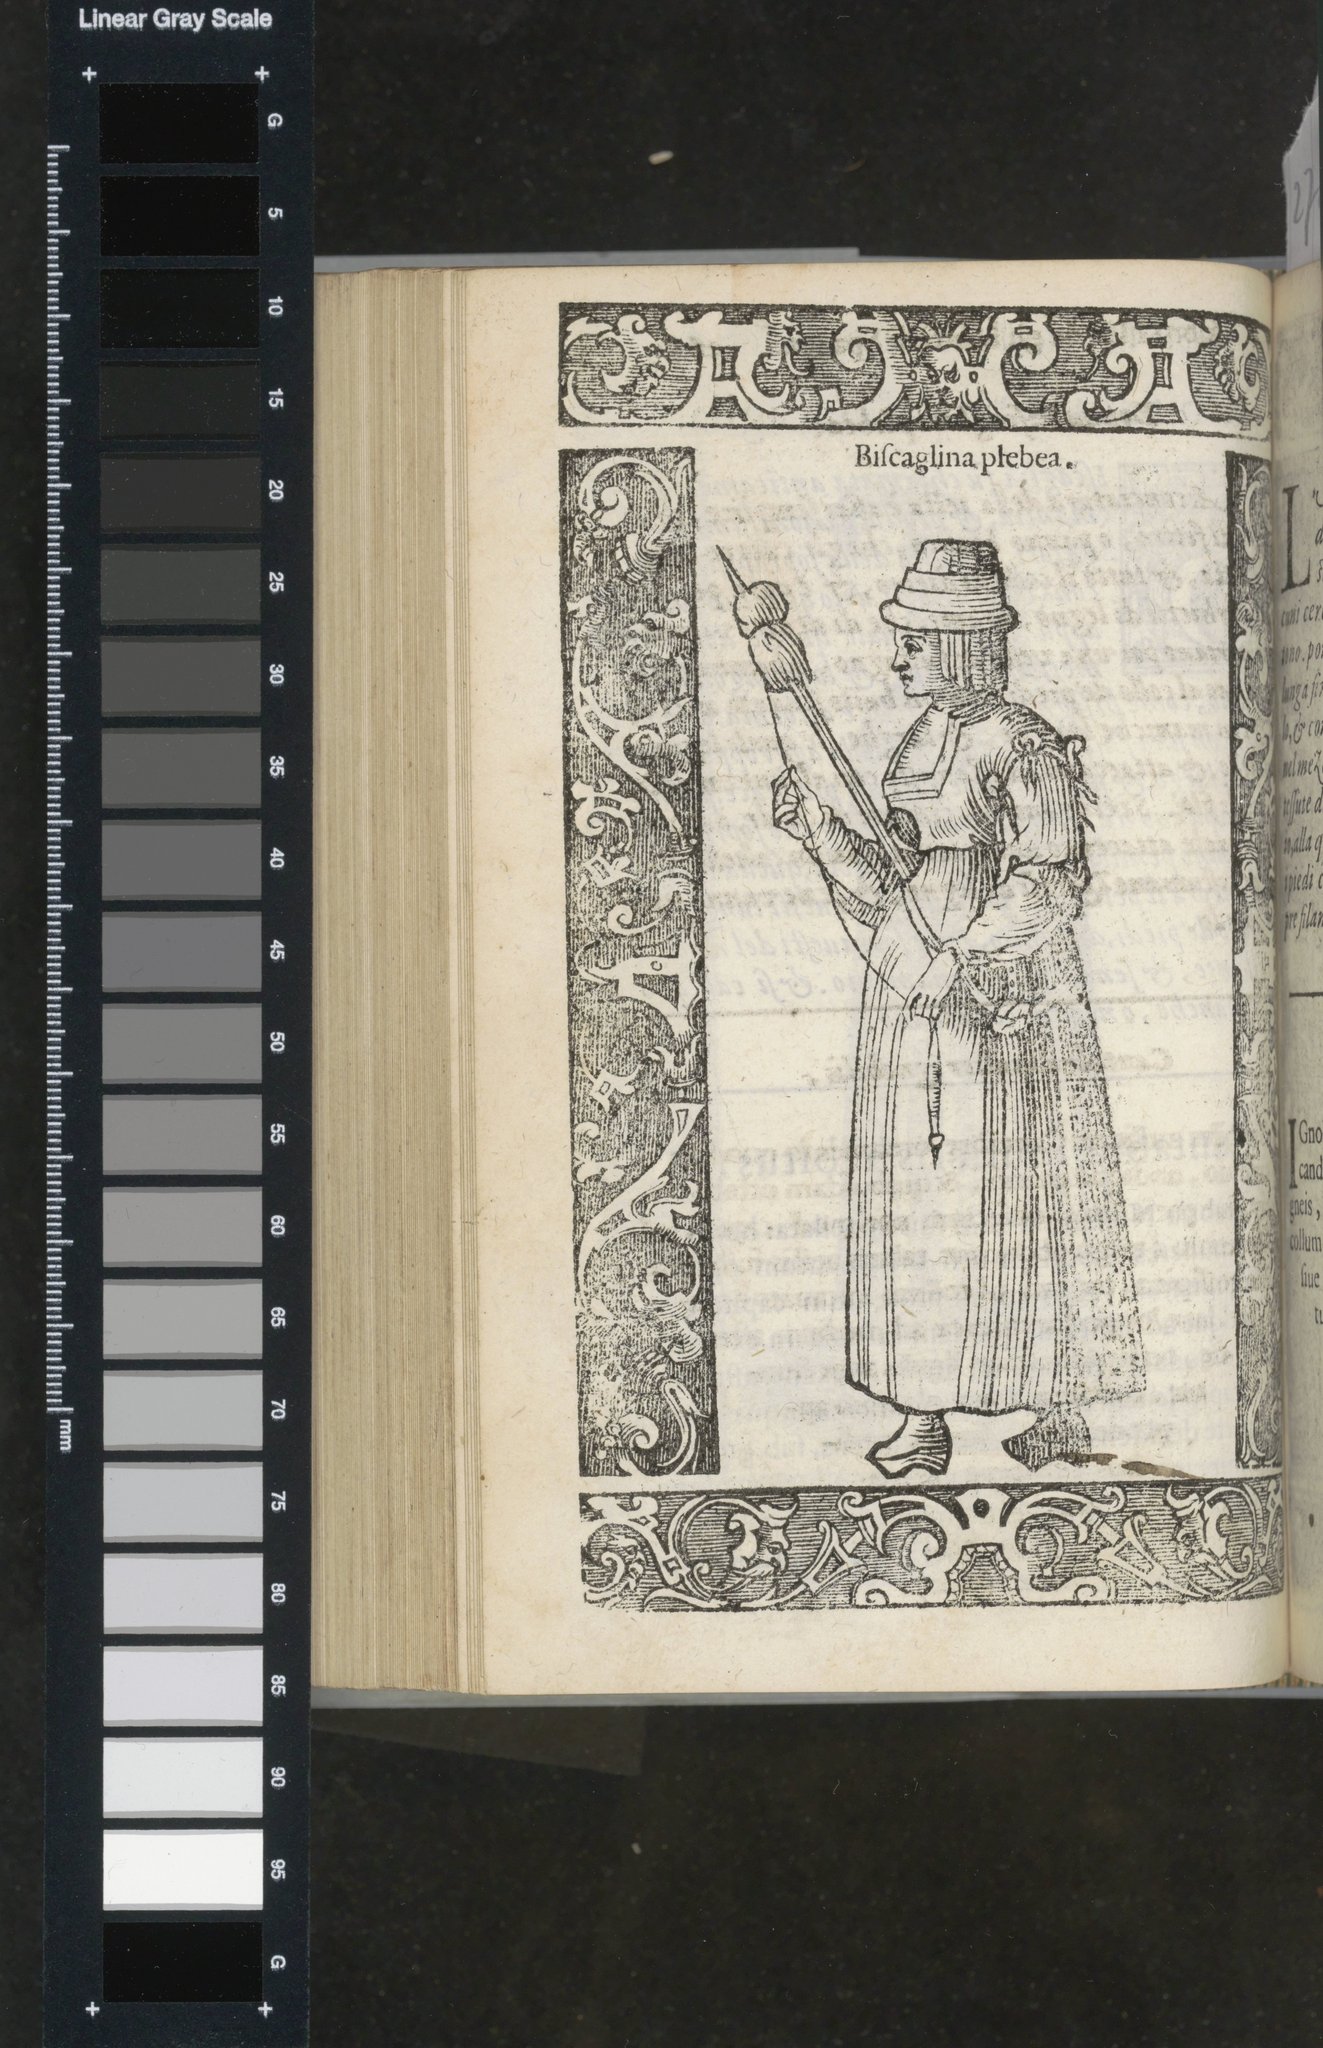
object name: costume print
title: Biscaglina plebeja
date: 1598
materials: paper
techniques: woodcut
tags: distaff, fashion plates, head-gear: hat (+ women's clothes), shoes, sandals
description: Volksvrouw van Biskaje, met spinrokken in de hand, een mes aan de gordel. Ze loopt op ‘zoccoli' (trippen).